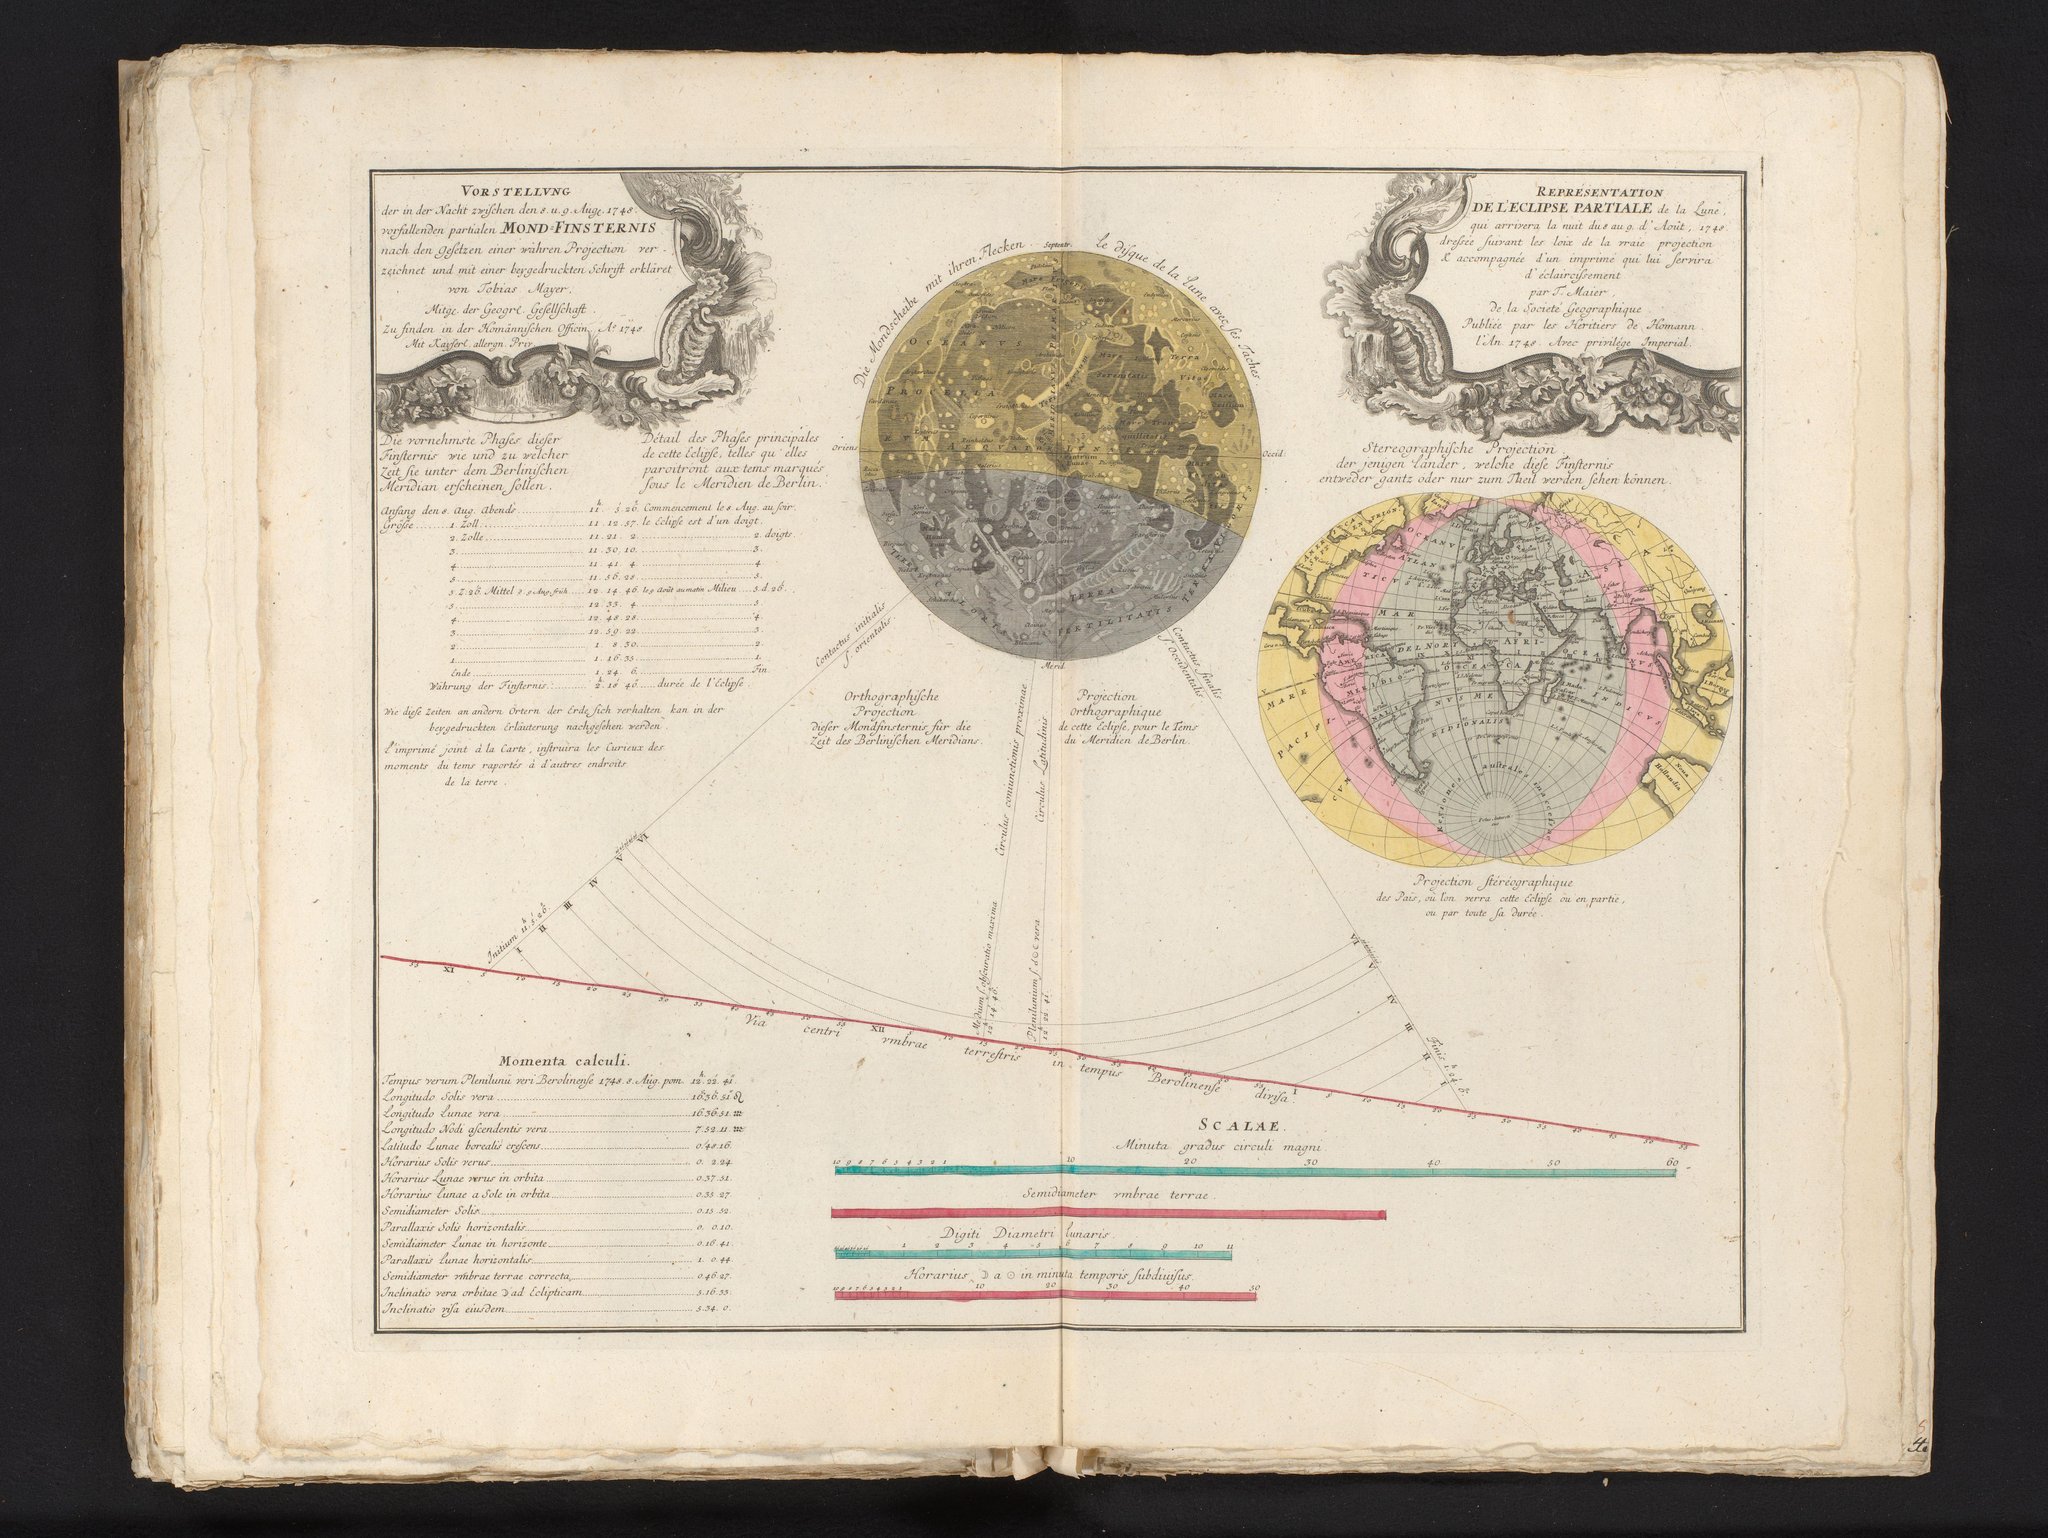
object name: print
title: Vorstellung der in der Nacht zwischen den 8 u. 9 aug. 1748 vorfallenden (...) / Representation de l'eclipse partiale de la lune qui arrivera (...)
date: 1748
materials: paper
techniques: engraving, etching, hand coloring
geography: nuremberg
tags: eclipse of the moon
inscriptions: date